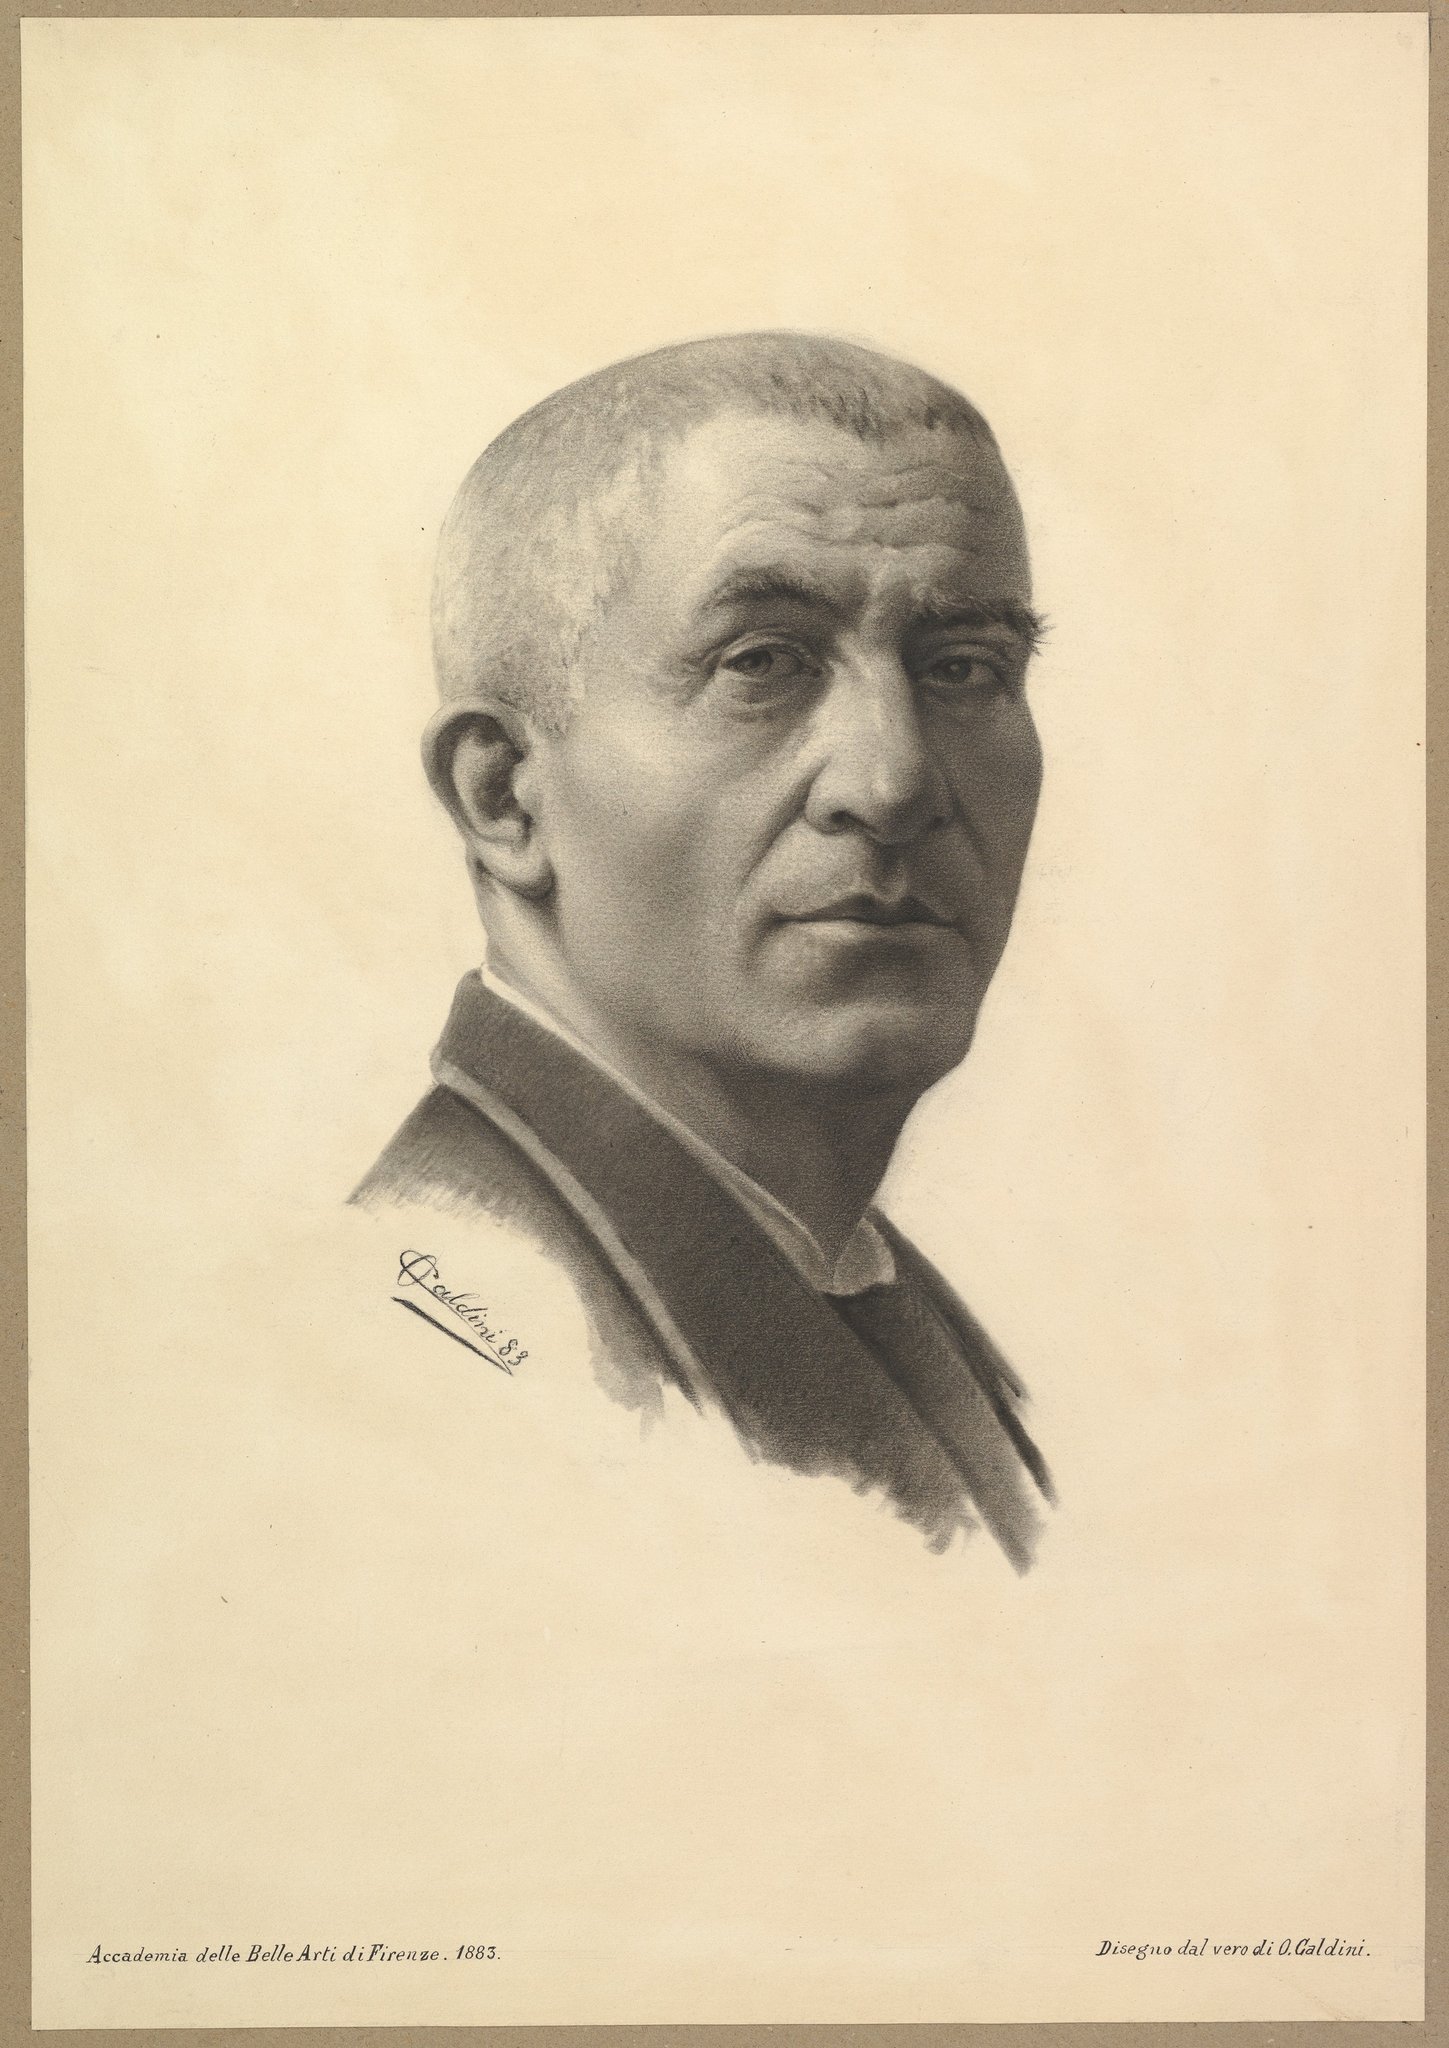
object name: drawing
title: Portrait Head of a Man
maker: oresto caldini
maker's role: artist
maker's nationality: italian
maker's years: 19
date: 1800-1900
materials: charcoal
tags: heads,men,portraits